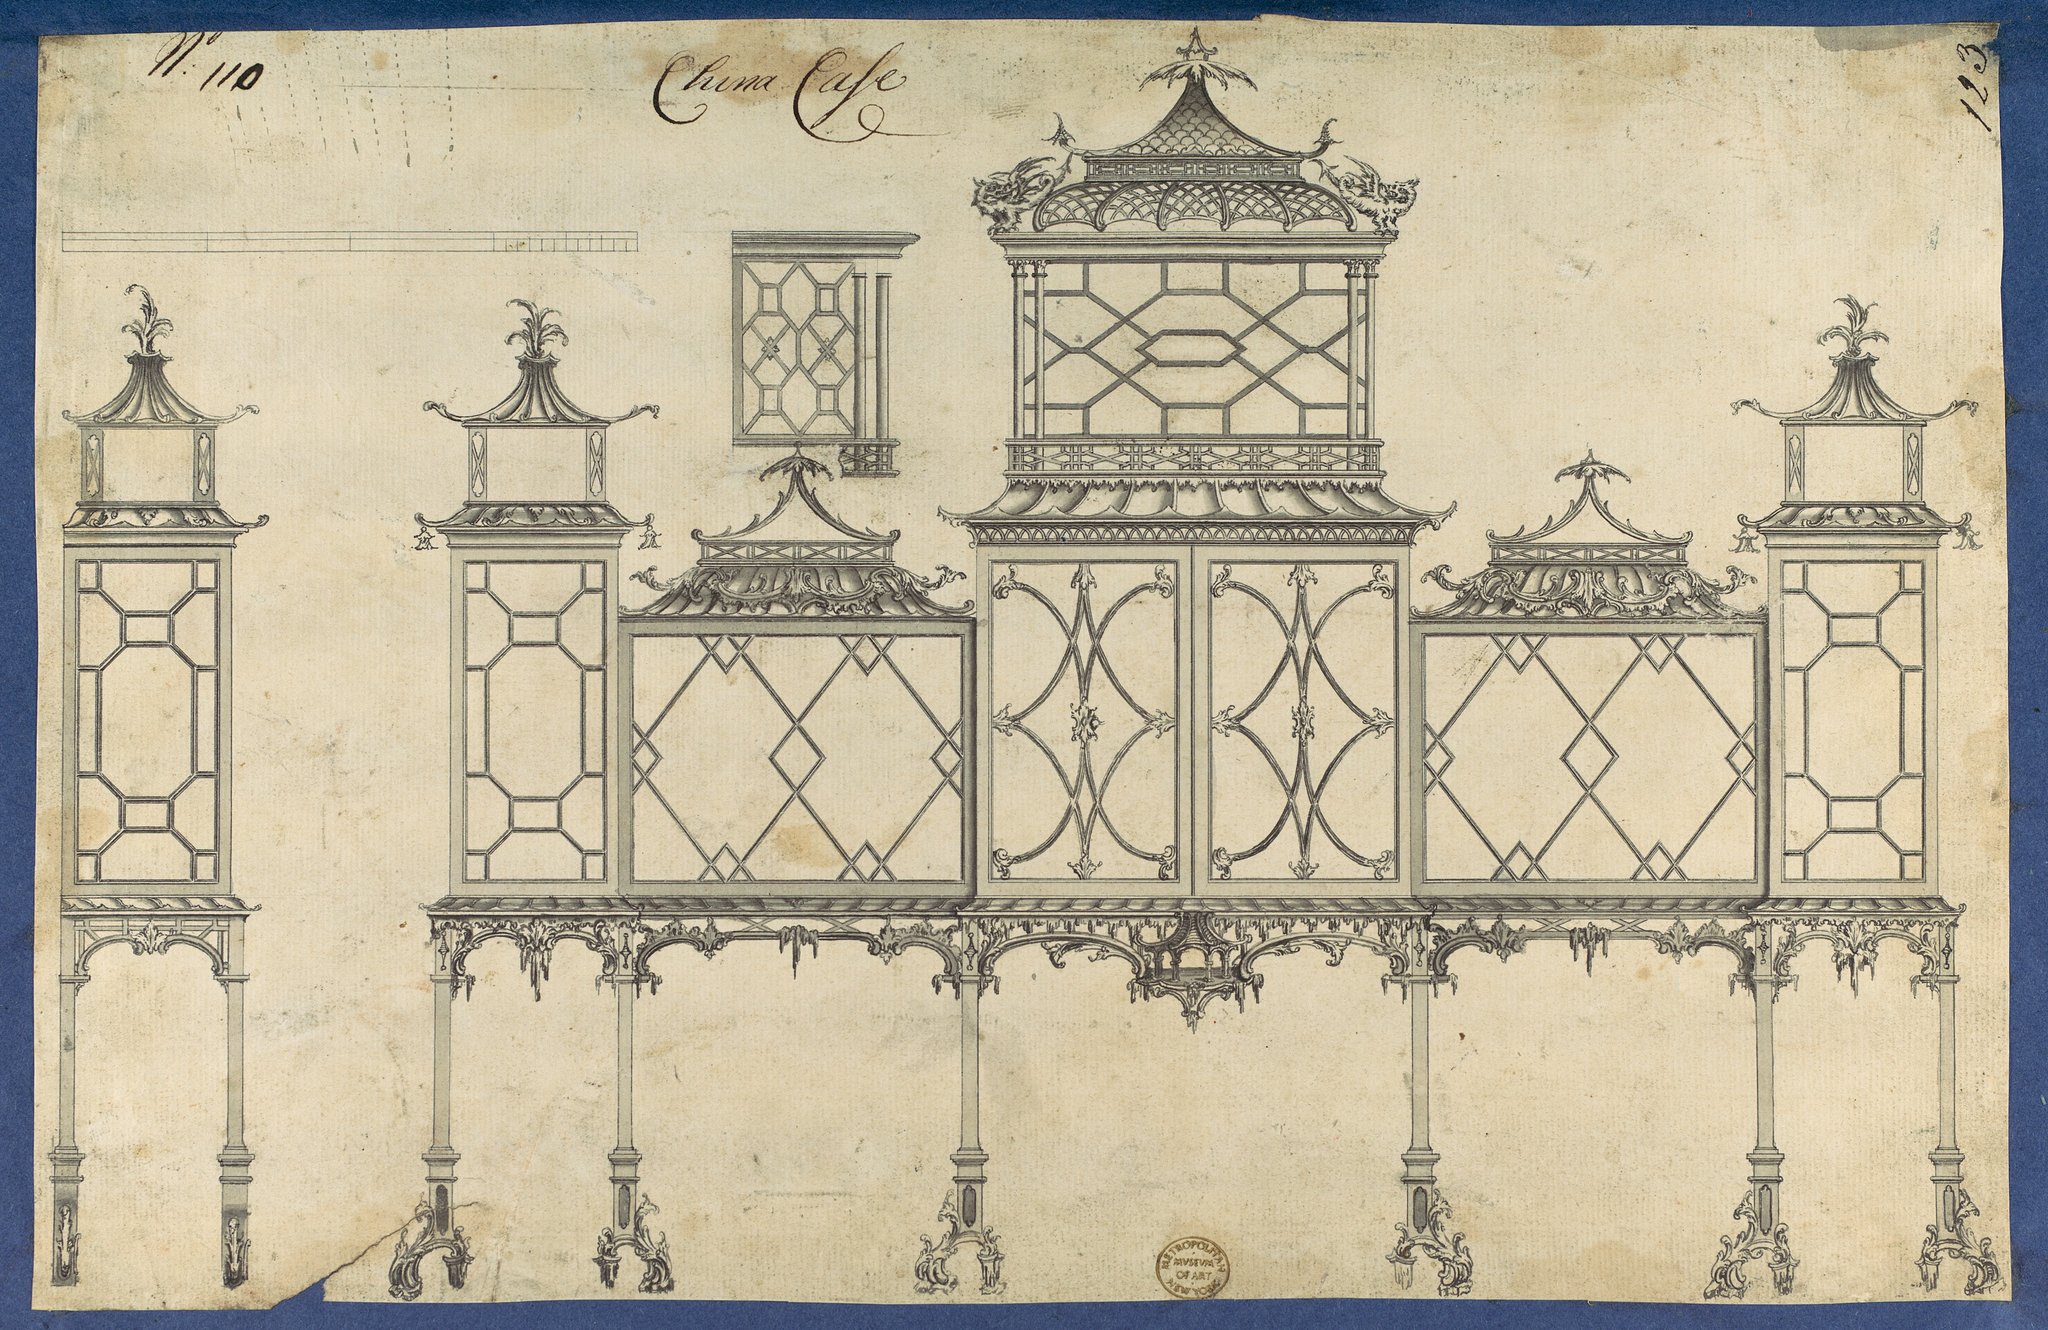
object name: drawing ornament architecture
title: China Case, from Chippendale Drawings, Vol. II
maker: thomas chippendale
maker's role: artist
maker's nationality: british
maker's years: 1718-1779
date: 1753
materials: ink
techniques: wash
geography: london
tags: furniture